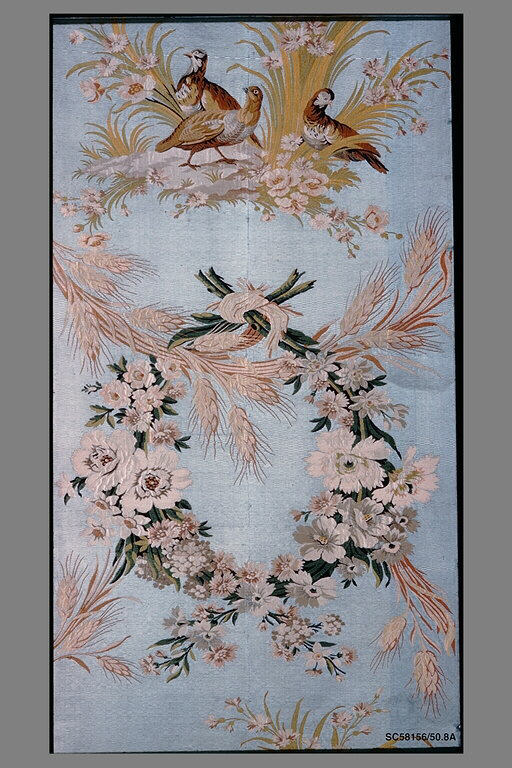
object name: upholstery textile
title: "Les Perdrix" (The Partridges)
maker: philippe de lasalle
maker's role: designer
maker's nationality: french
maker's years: 1723-1804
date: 1771-1772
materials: silk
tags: birds,garlands,flowers